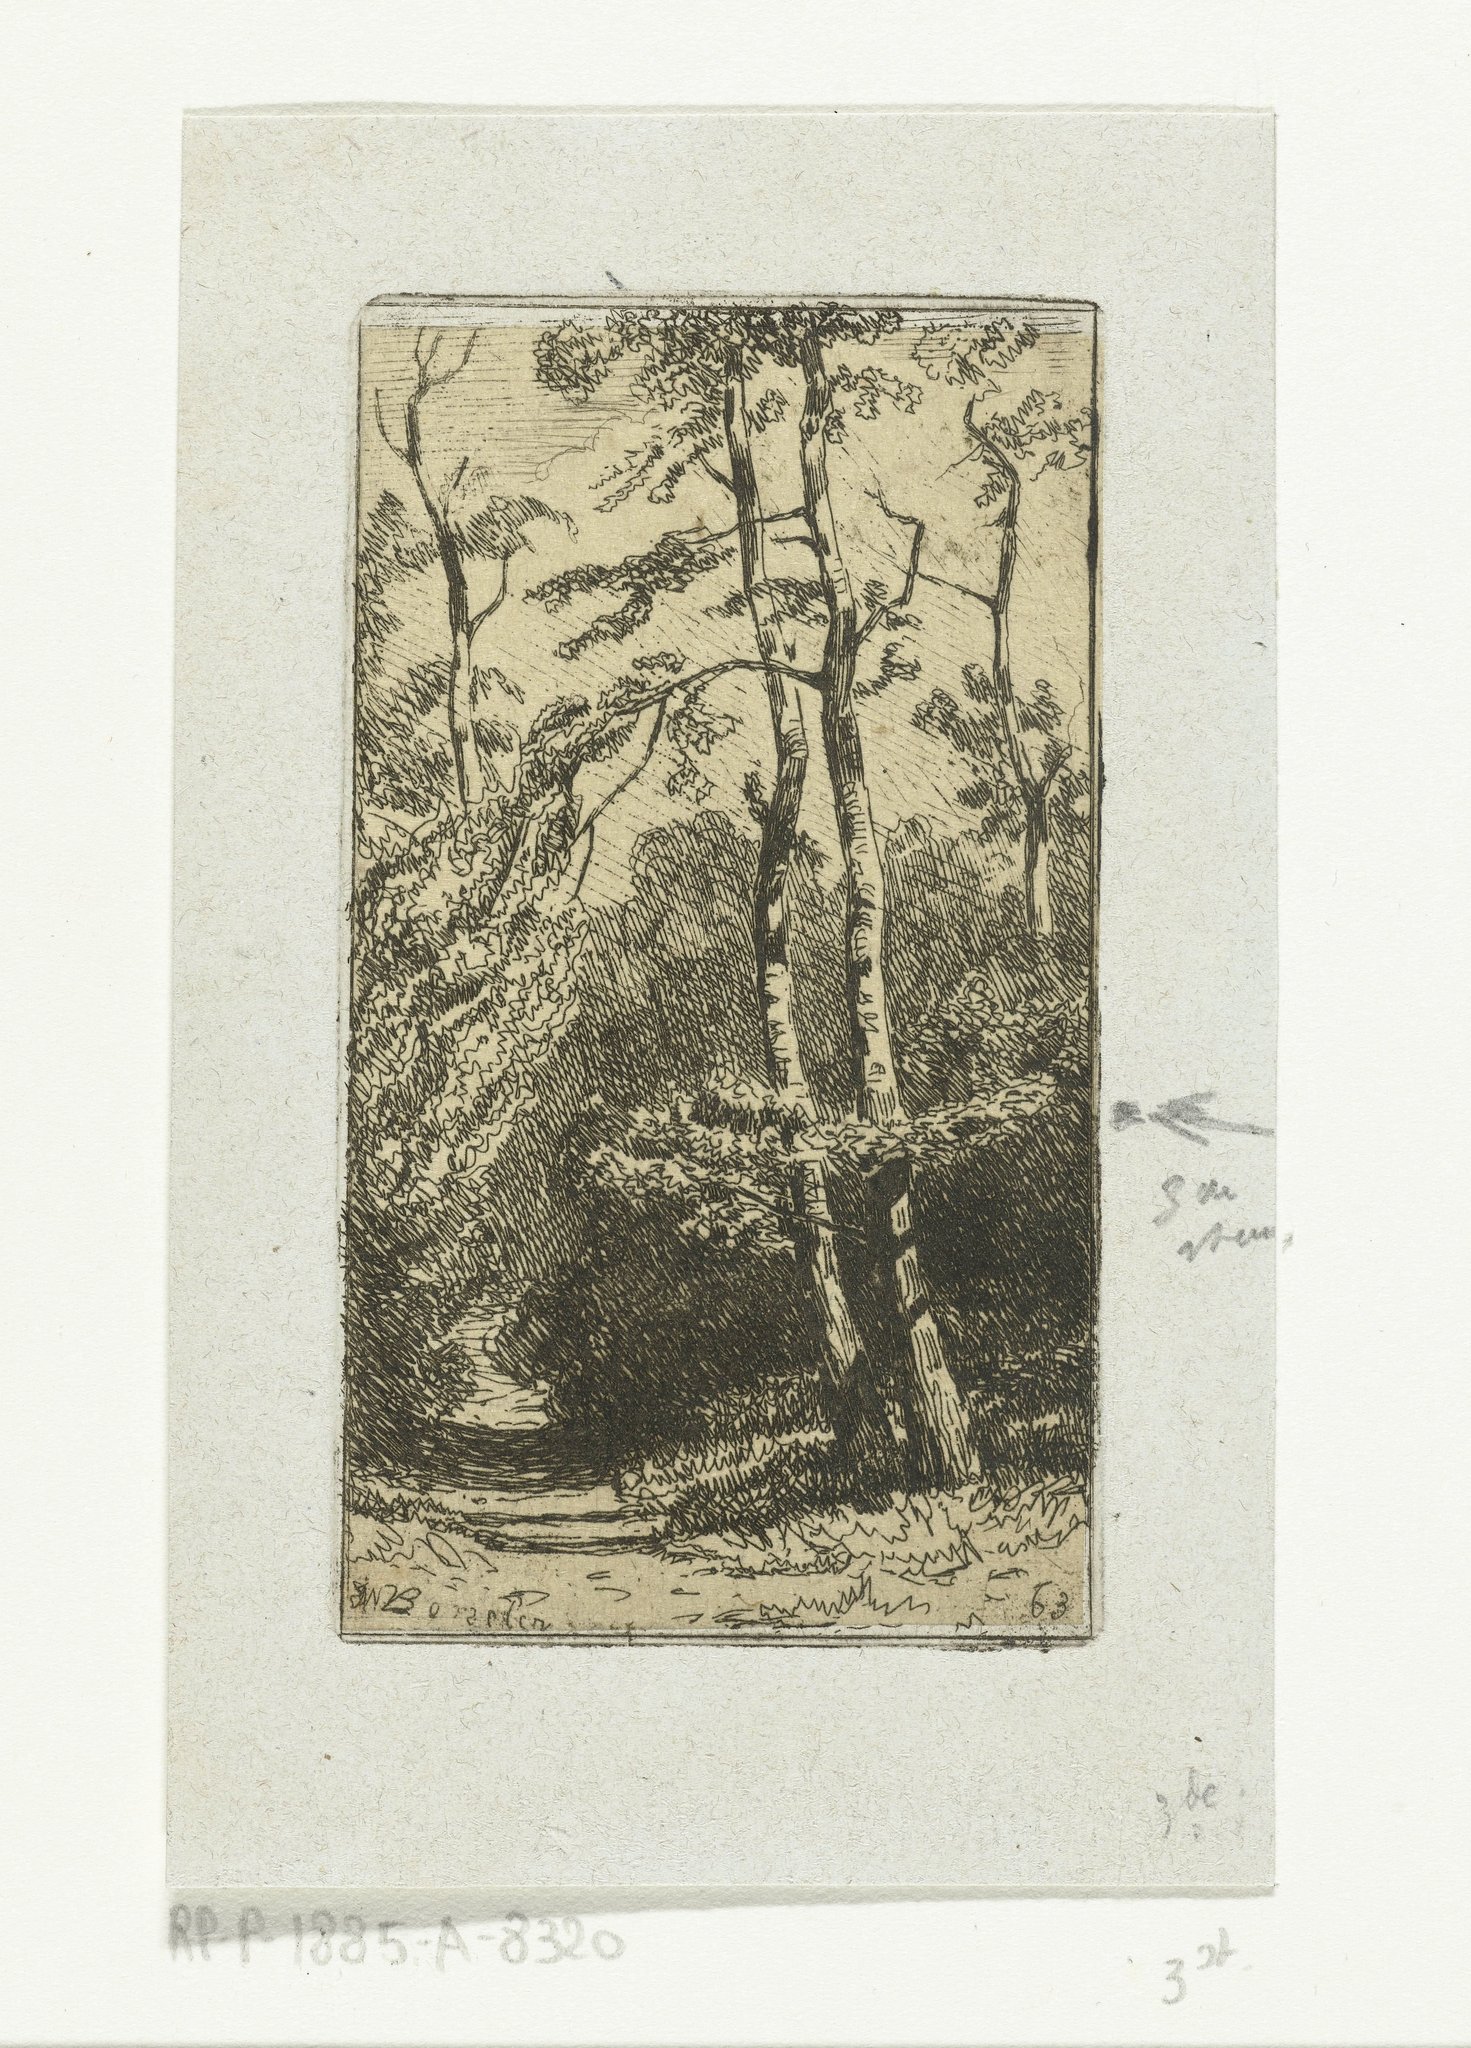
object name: print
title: Landschap met berken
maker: jan willem van borselen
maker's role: draughtsman, print maker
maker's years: 1825-1892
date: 1835-1858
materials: paper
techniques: etching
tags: forest path or lane, trees: birch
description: Landschap met een bosweggetje en enkele berken.